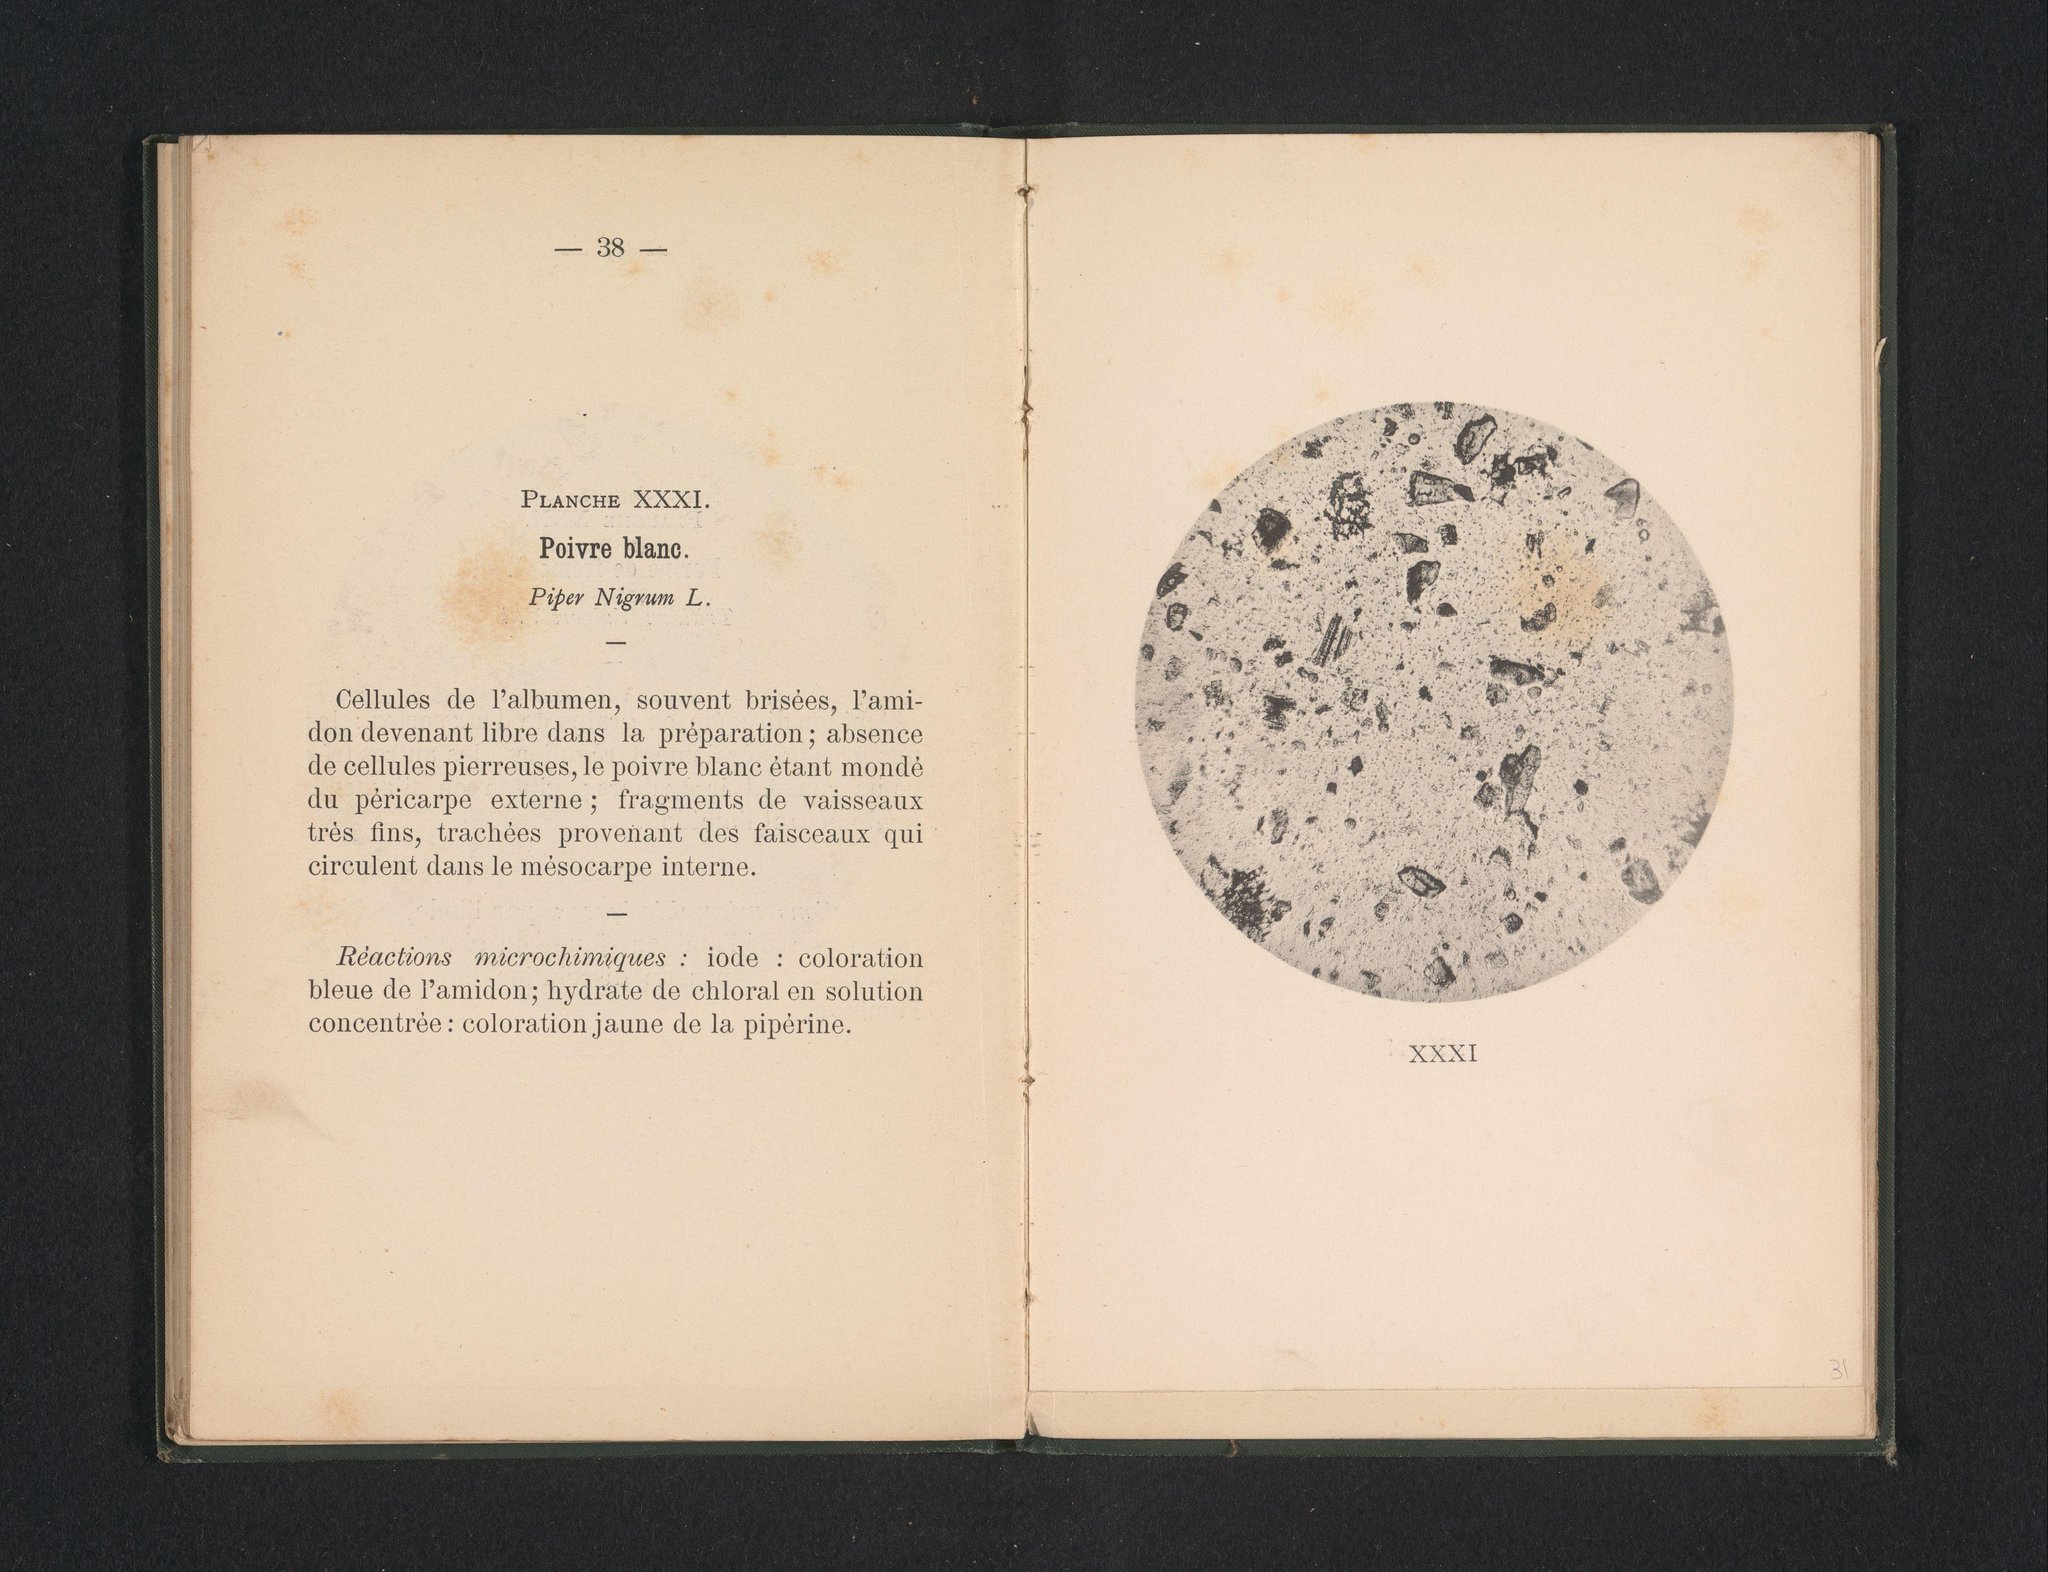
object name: photomechanical print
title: Microscopische weergave van witte peper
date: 1891-1896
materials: paper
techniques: photograph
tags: microscope (+ scientific research)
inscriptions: number: ‘XXXI’